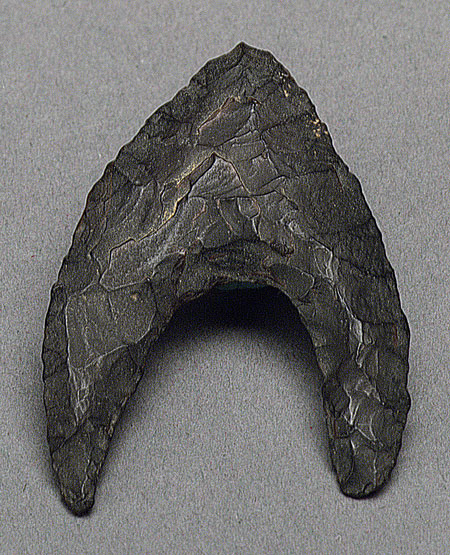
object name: arrowhead, hollow base, projectile point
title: Hollow-Base Projectile Point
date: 7000-4500 BCE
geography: egypt